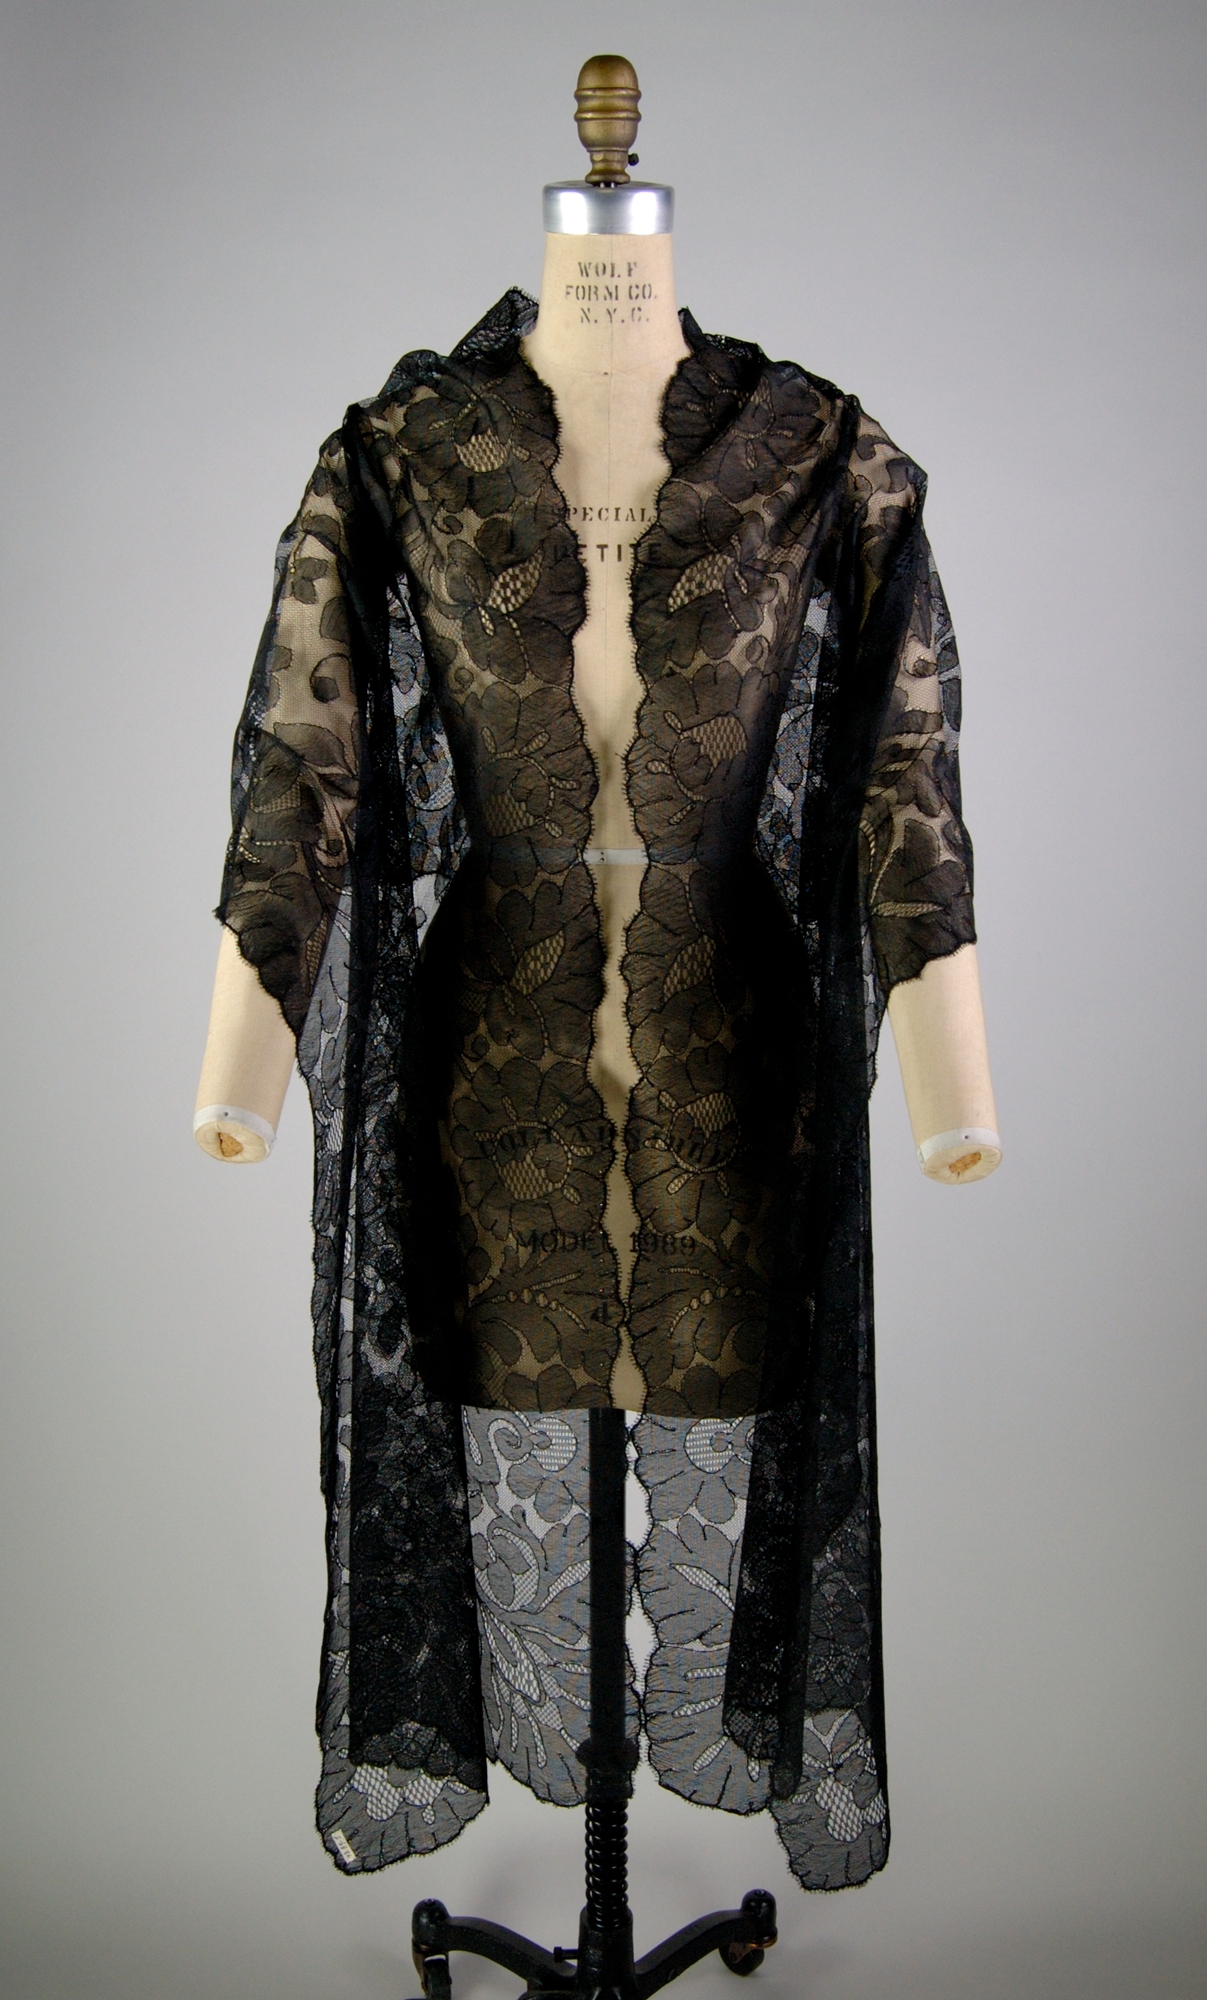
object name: stole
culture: spanish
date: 1876-1900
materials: silk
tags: flowers